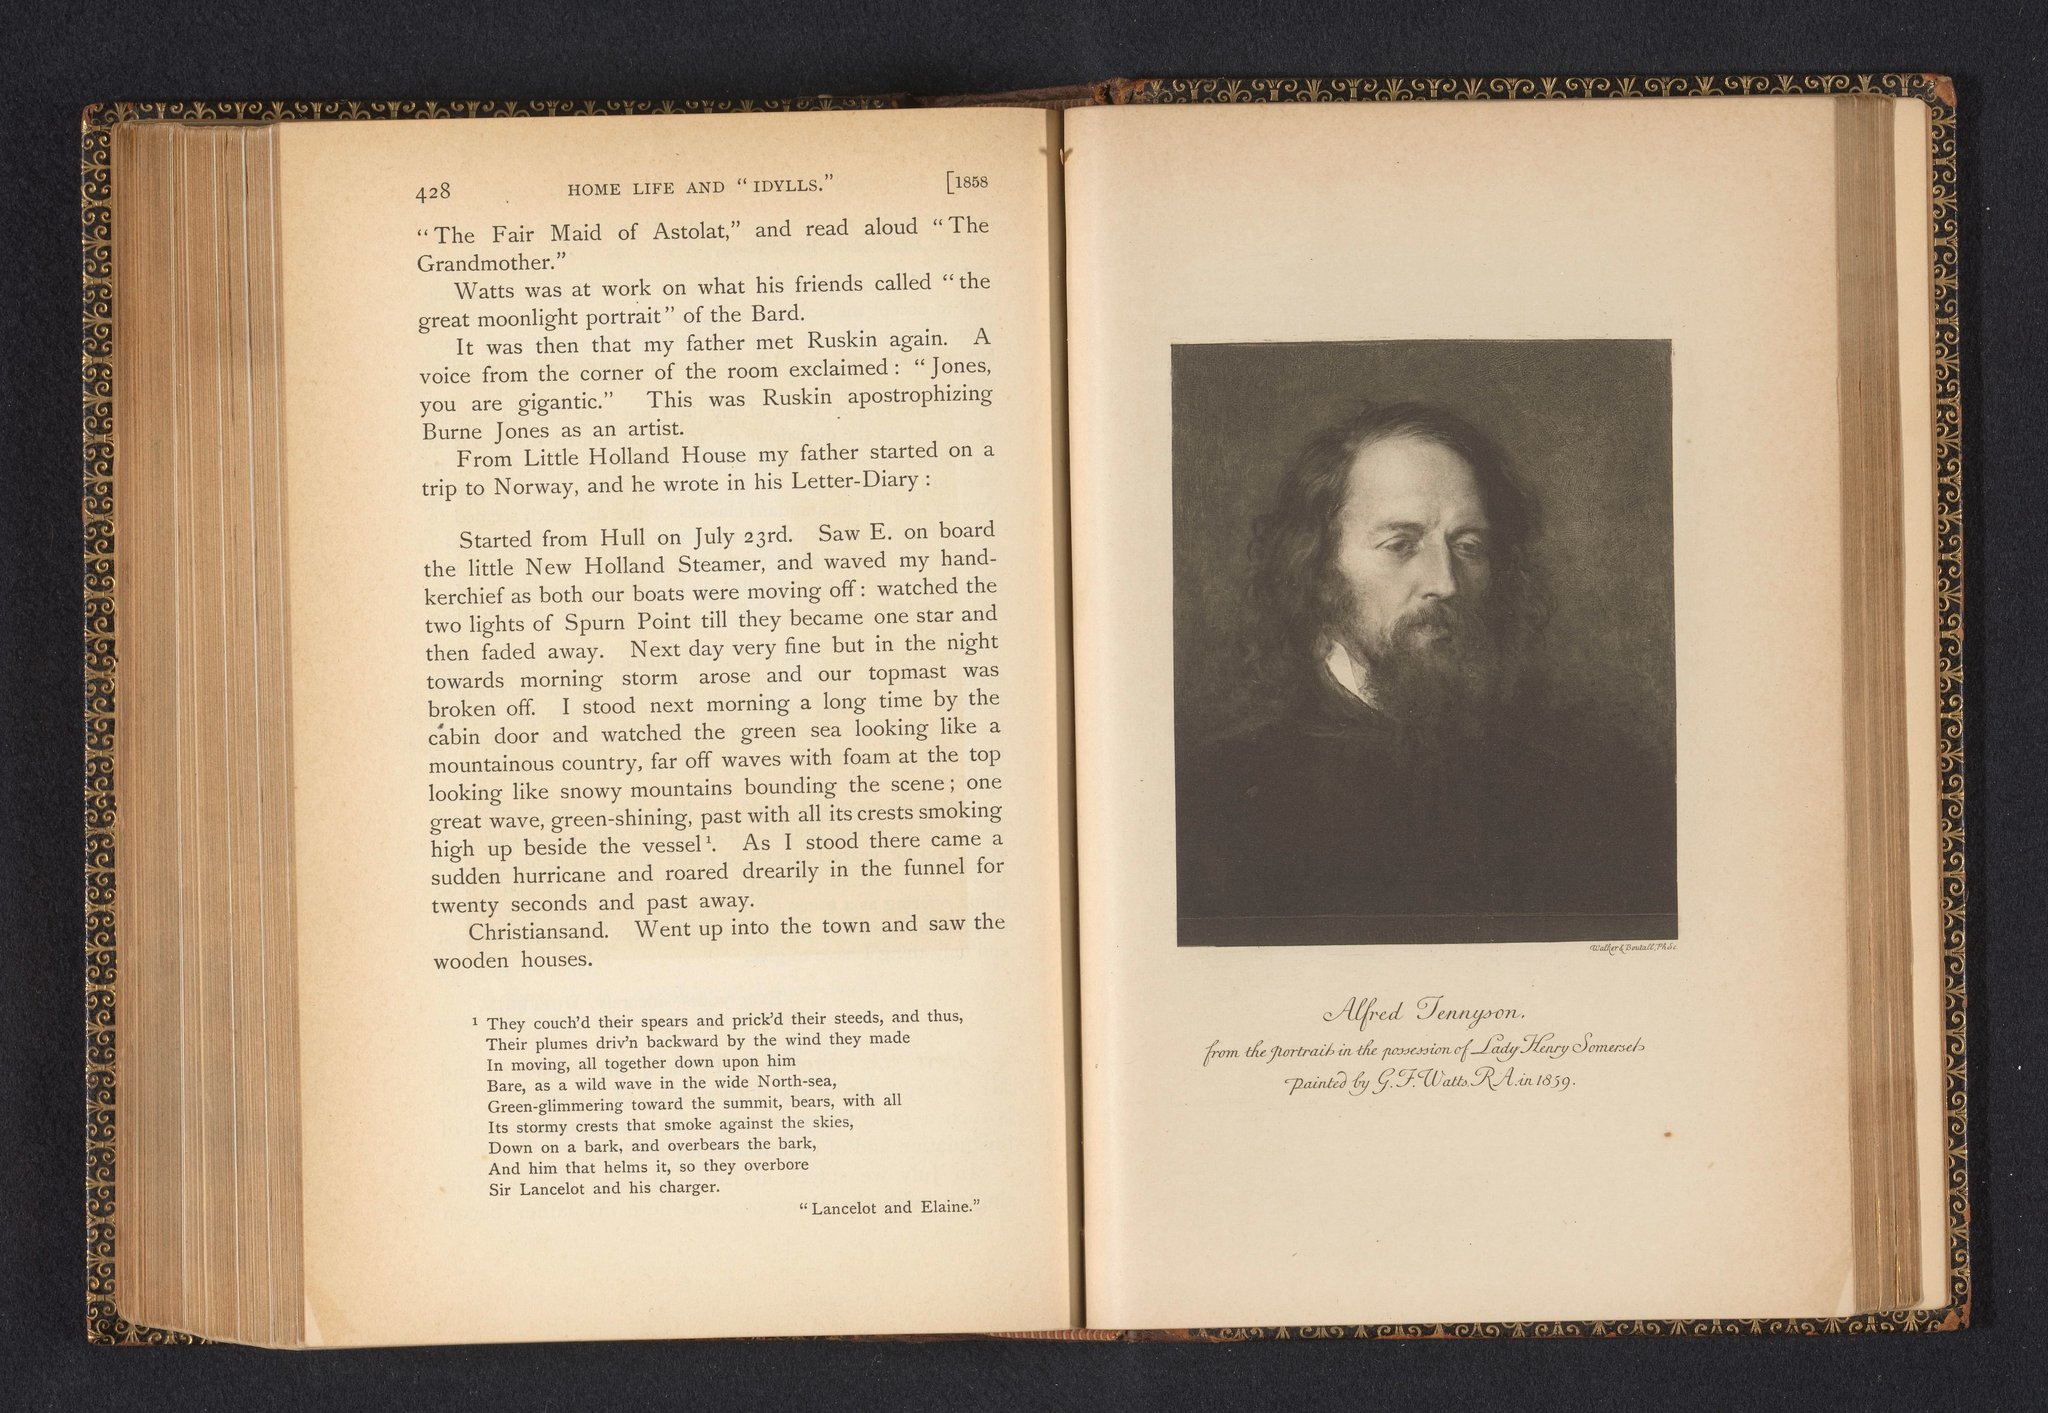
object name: photomechanical print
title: Alfred Tennyson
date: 1887-1897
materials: paper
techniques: photoaquatint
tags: alfred tennyson, portrait of a writer